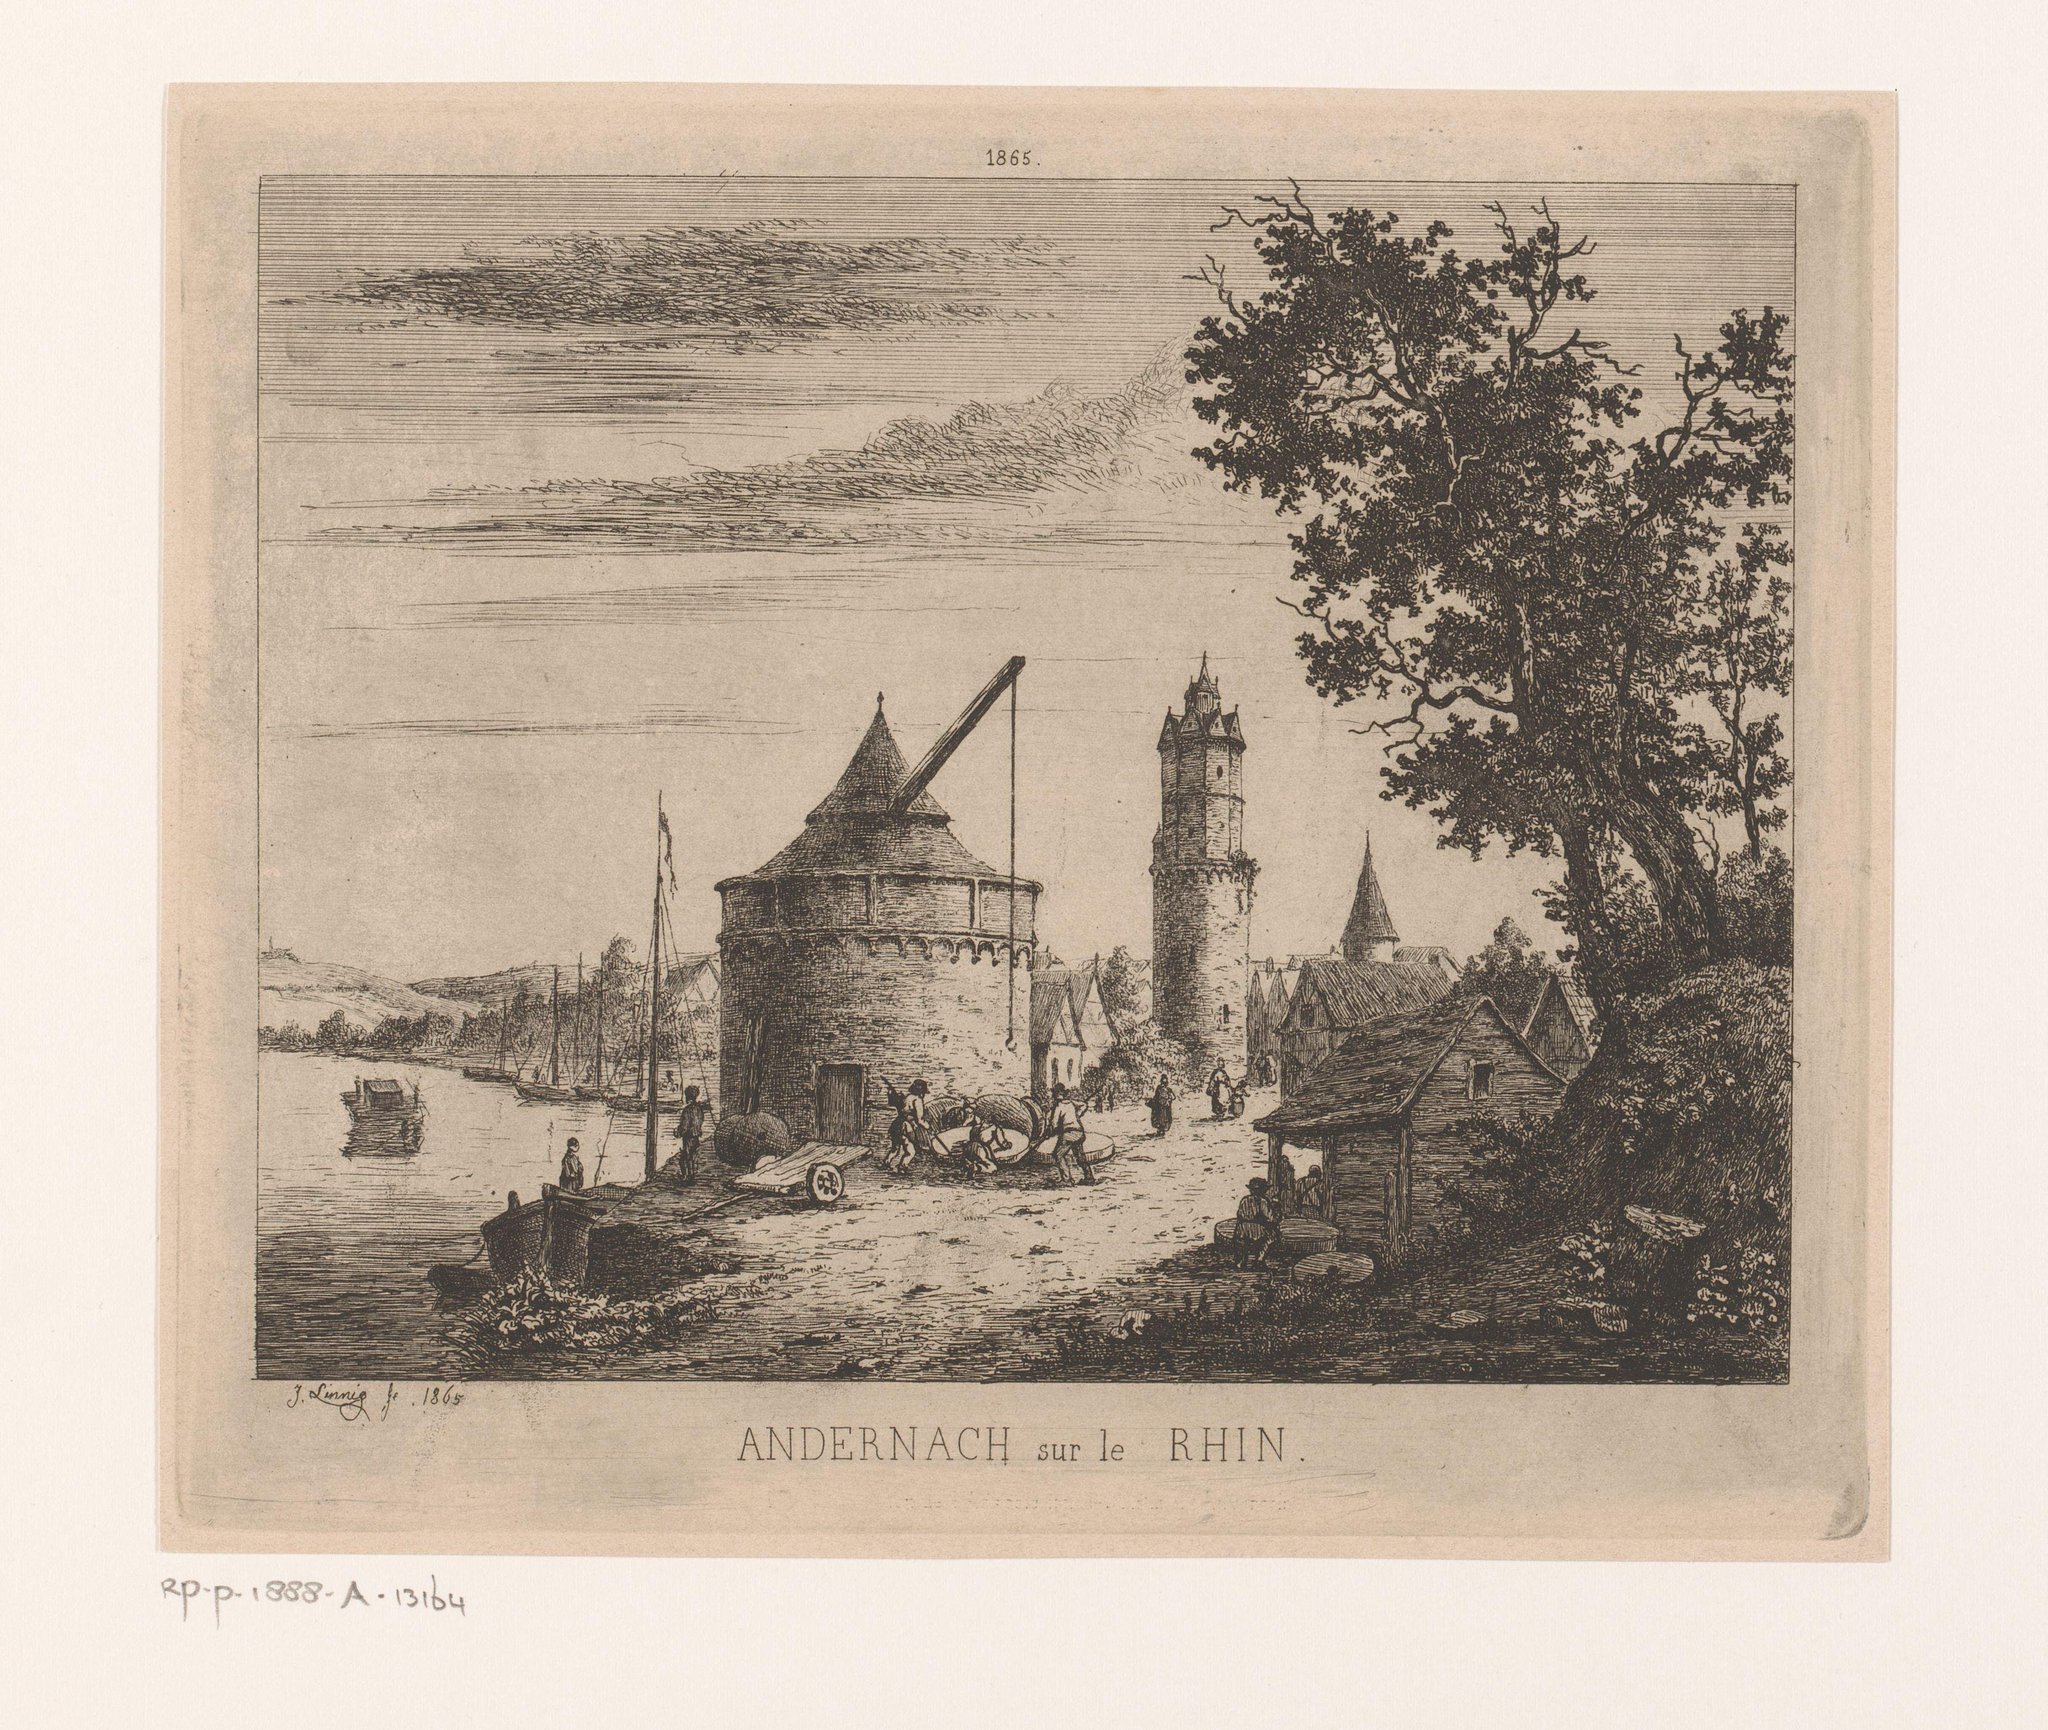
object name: print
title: Andernach sur le Rhin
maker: jean théodore joseph linnig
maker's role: draughtsman, print maker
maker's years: 1815-1891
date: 1865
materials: paper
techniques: etching, intaglio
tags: river, towers ~ fortified city, dock crane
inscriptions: collector's mark: Lugt 2228